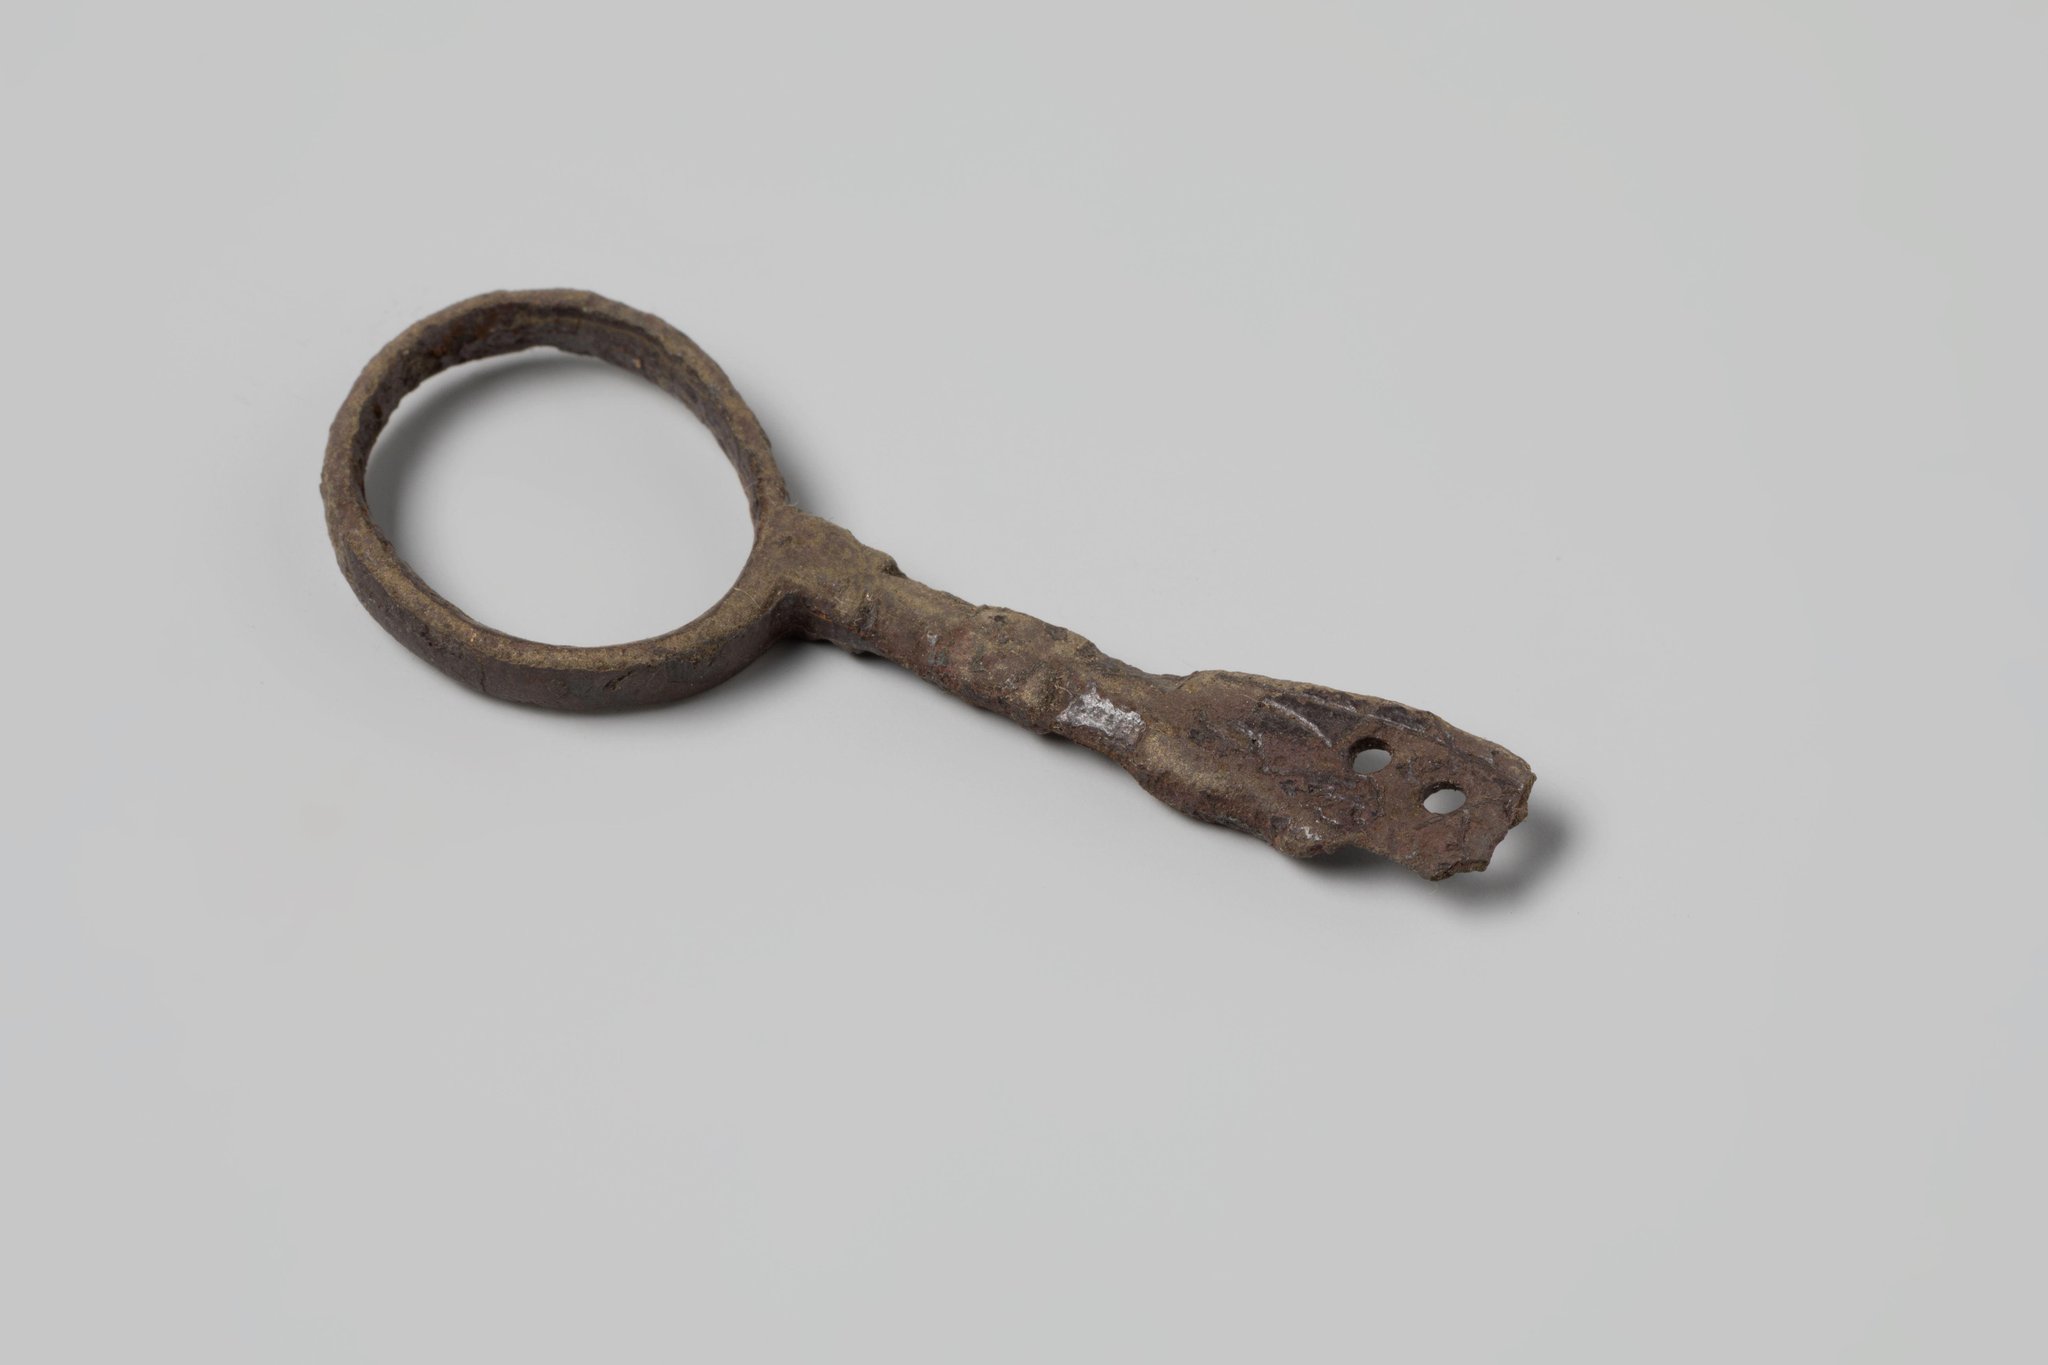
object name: pin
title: Speld uit het wrak van de Oost-Indiëvaarder Hollandia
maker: Anonymous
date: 1700-1743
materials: copper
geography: netherlands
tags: verenigde oostindische compagnie, hollandia (schip), annet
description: Tools and instruments, sewing and sailmaking, pin; fragm of shaft with bow, id. NG 1980-27H3265.